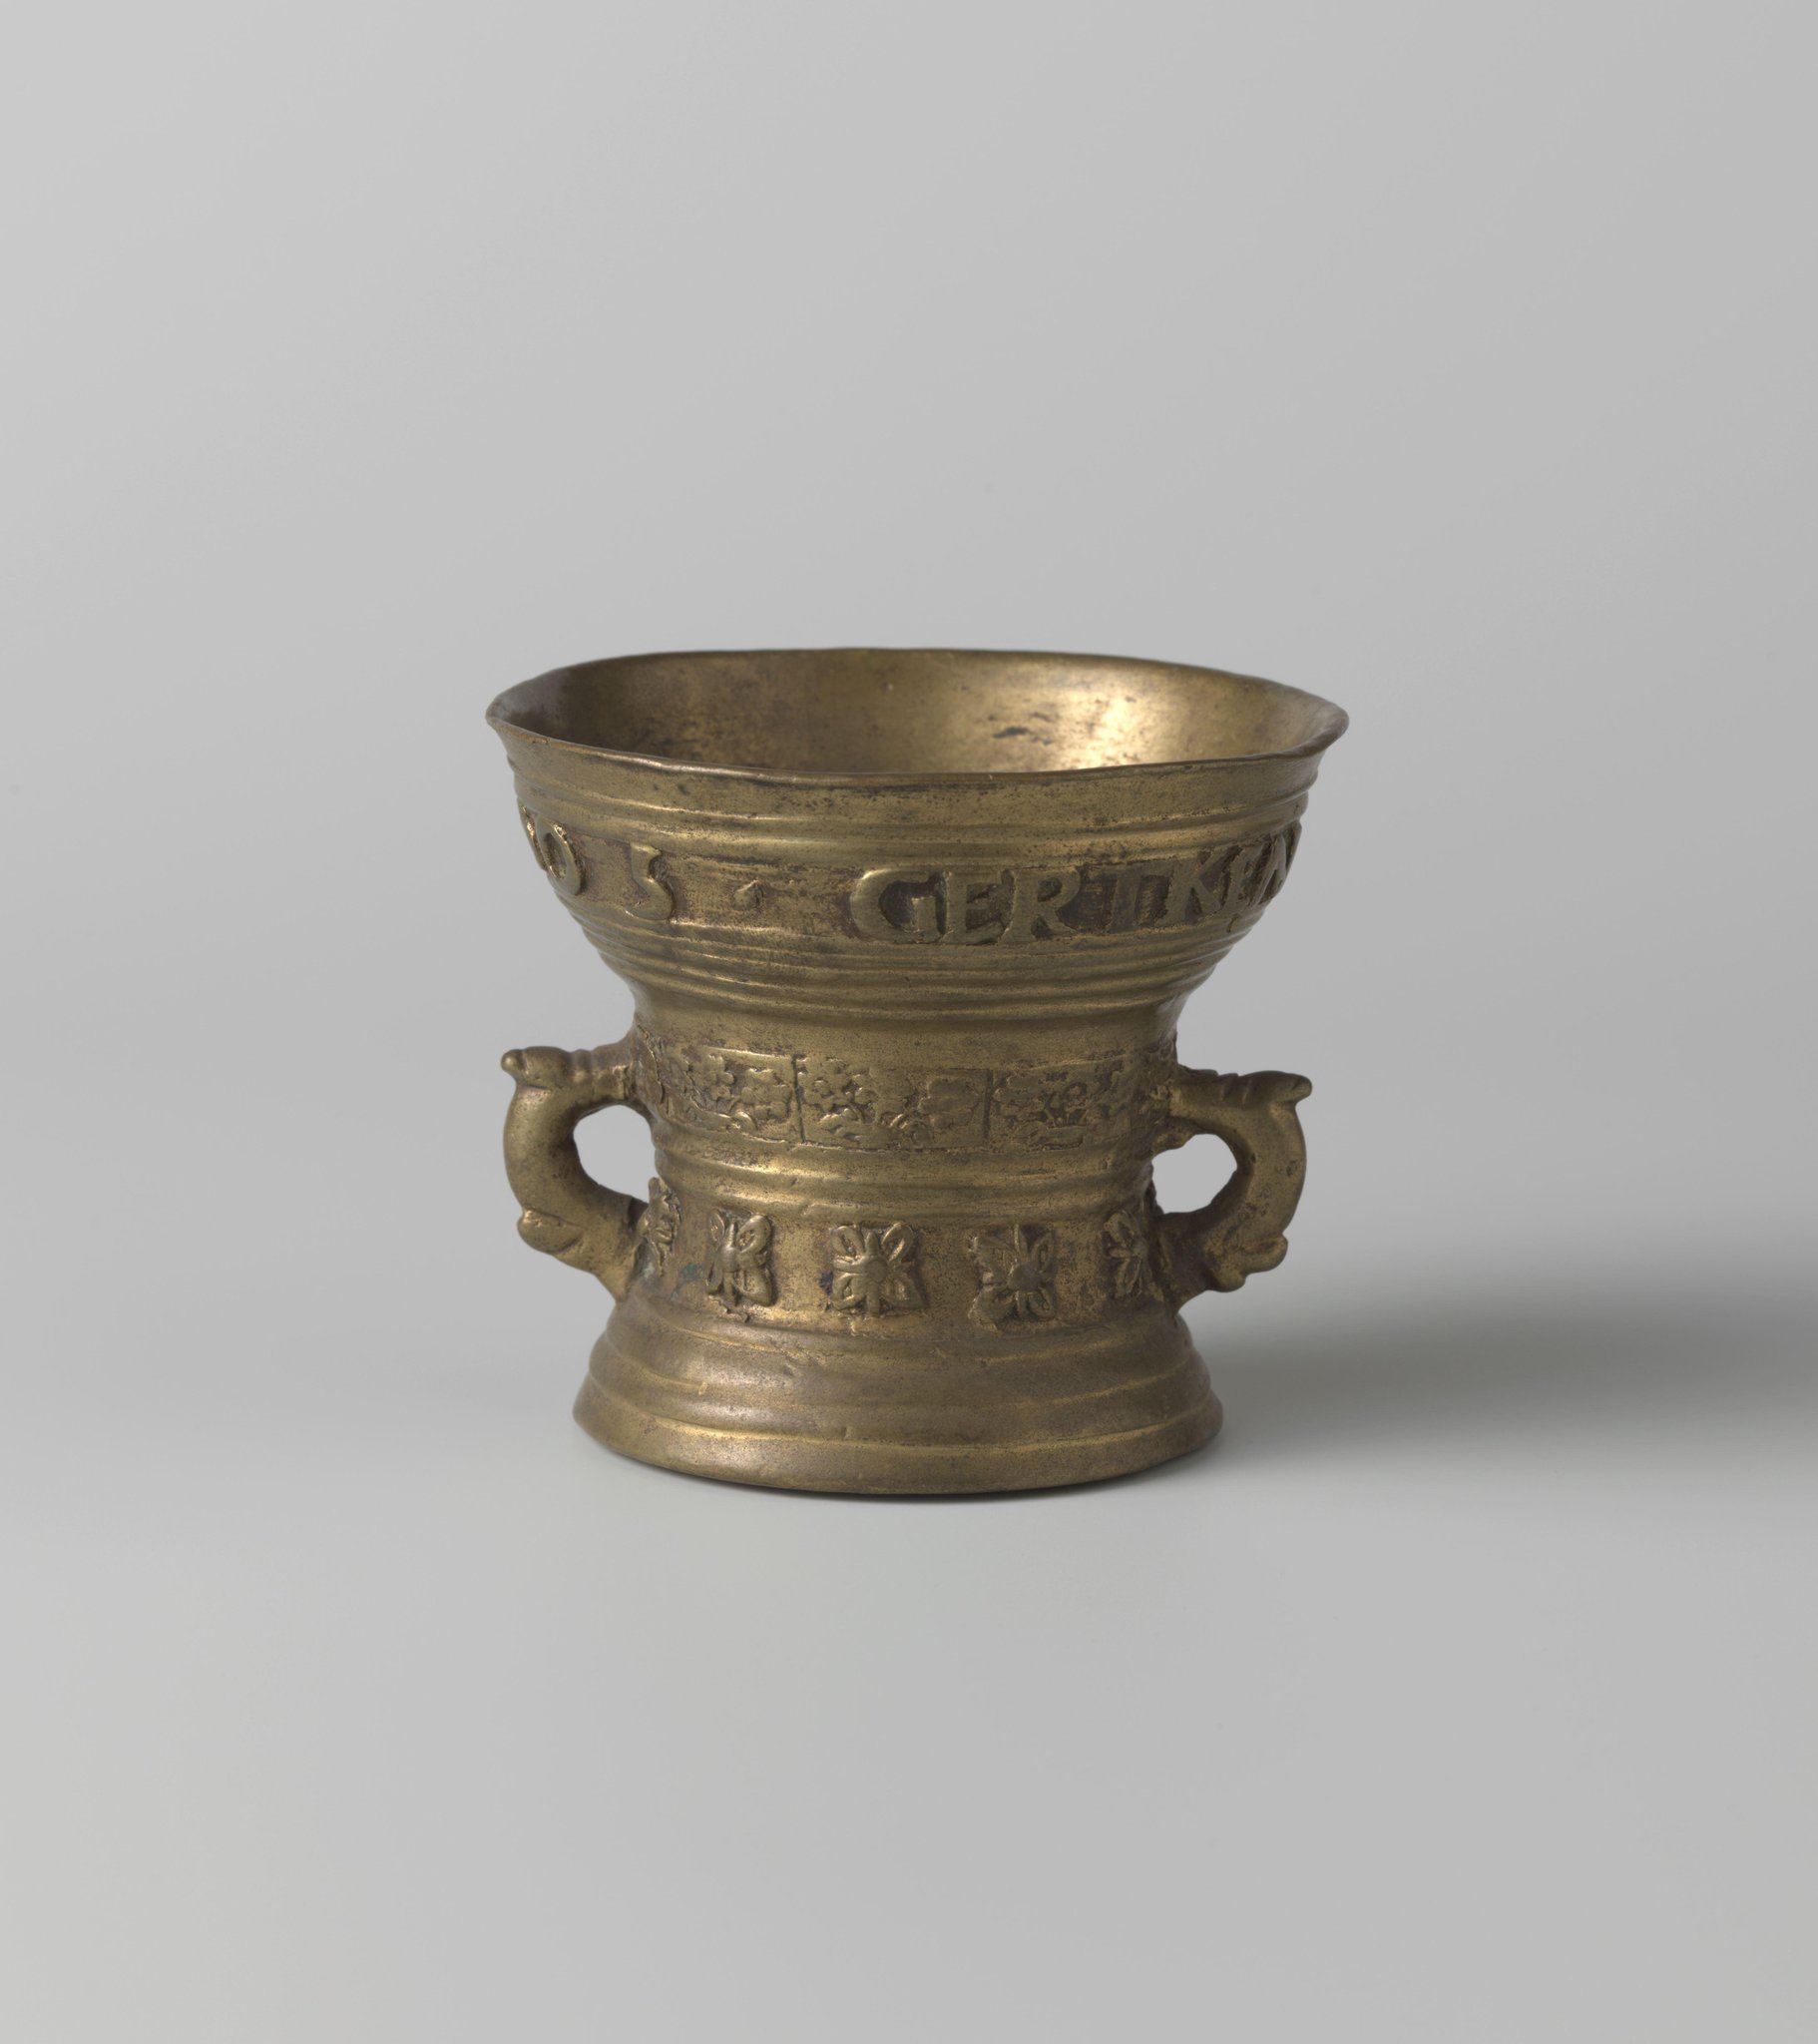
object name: mortar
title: Vijzel met opschrift GERTKEN WLFFERS Ao 1605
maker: hendrick wegewart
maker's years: 1585-1624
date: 1605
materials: bronze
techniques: casting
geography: northern netherlands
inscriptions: inscription: ‘GERTKEN.WLFFERS.Ao.1605.’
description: De gegoten ronde vijzel verbreedt zich naar boven toe, heeft een uitkragende geprofileerde rand en een uitlopende geprofileerde voet. Op de rand in Latijnse majuskels het opschrift GERTKEN WLFFERS Ao 1605 met interpuncties bestaande uit een ruit (vier keer). Het bovenste fries bestaat uit een herhaling van drie bloemen op stelen in platte schaal. Het onderste fries bestaat uit een herhaling van een vierbladig rozet. Eenvoudige dolfijnenoren.